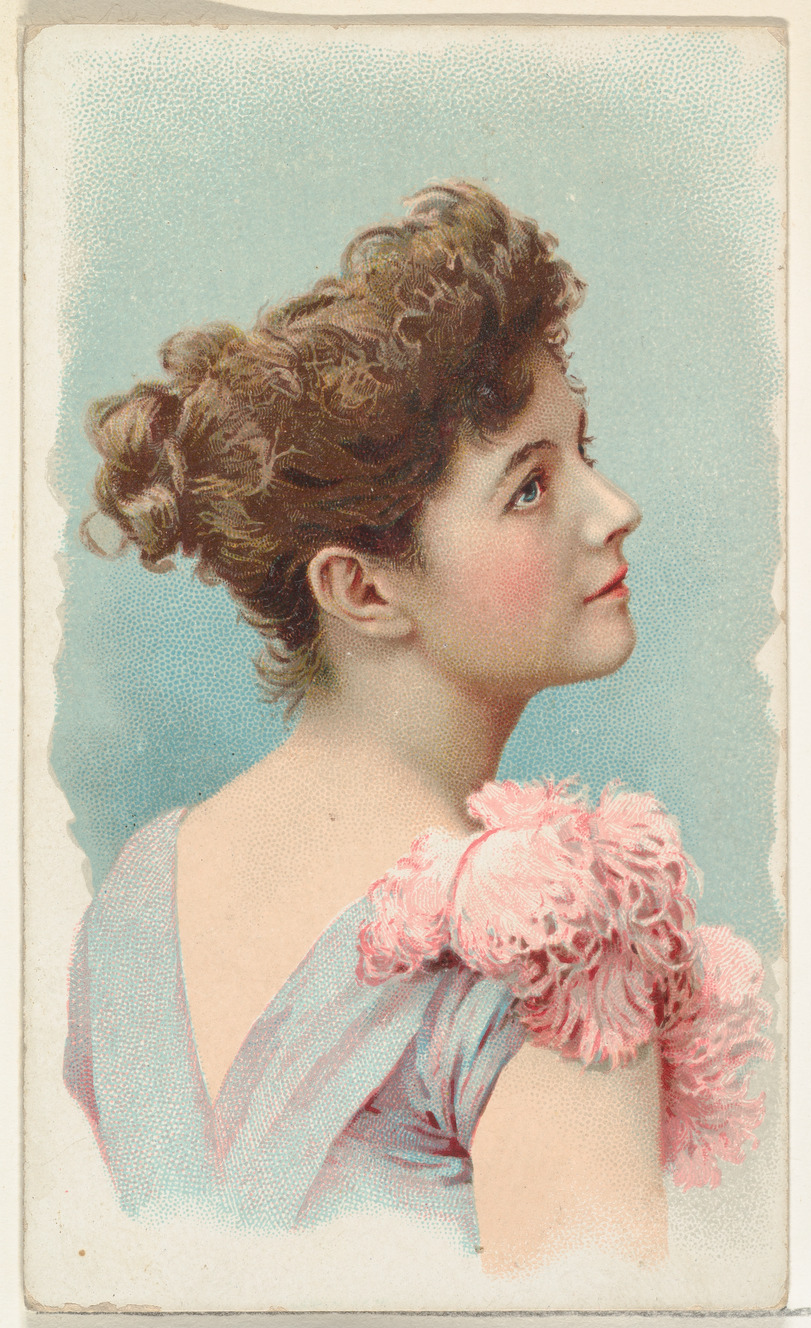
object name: print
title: Actress in profile wearing pink feather on shoulder, from Stars of the Stage, First Series (N129) issued by W. Duke, Sons & Co. to promote Honest Long Cut Tobacco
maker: w. duke, sons & co.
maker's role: publisher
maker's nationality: american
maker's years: 1870-1920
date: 1890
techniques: color lithograph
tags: portraits,women,actresses